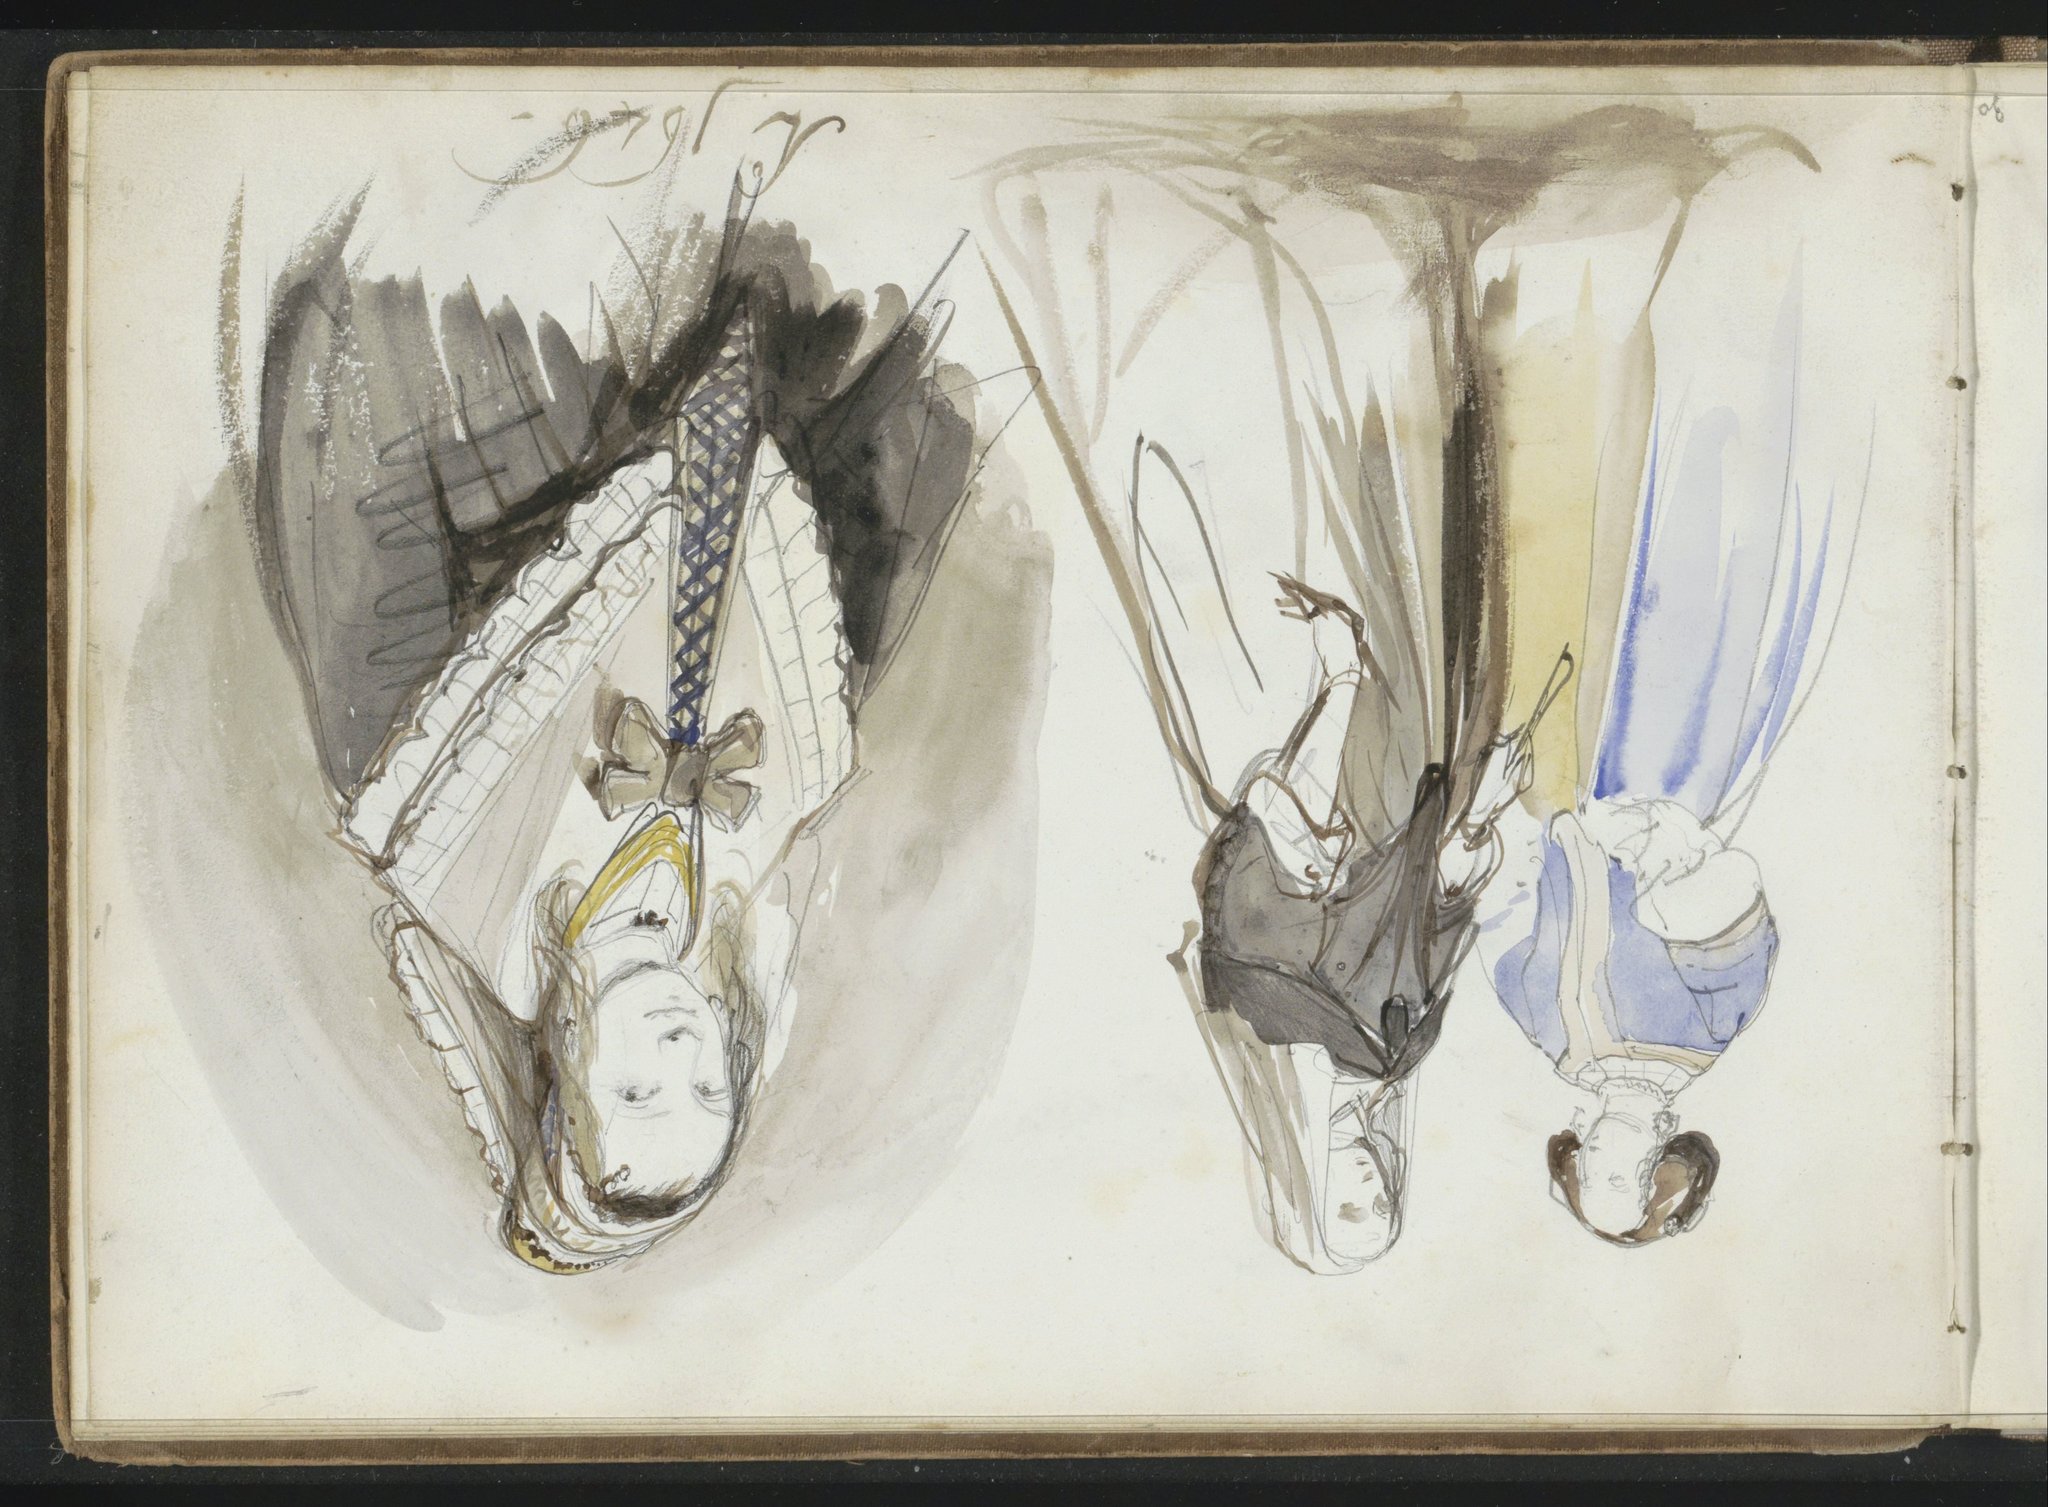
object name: sketchbook leaf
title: Vrouwenportretten, vermoedelijk kopieën naar zeventiende-eeuwse schilderijen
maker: johannes bosboom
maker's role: draughtsman, painter, print maker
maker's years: 1817-1891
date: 1827-1891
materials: paper, pencil, watercolor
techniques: brush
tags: adult woman, historical costume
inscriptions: annotation: ‘A 1646.’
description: Blad 6 verso uit een schetsboek met 41 pagina's.